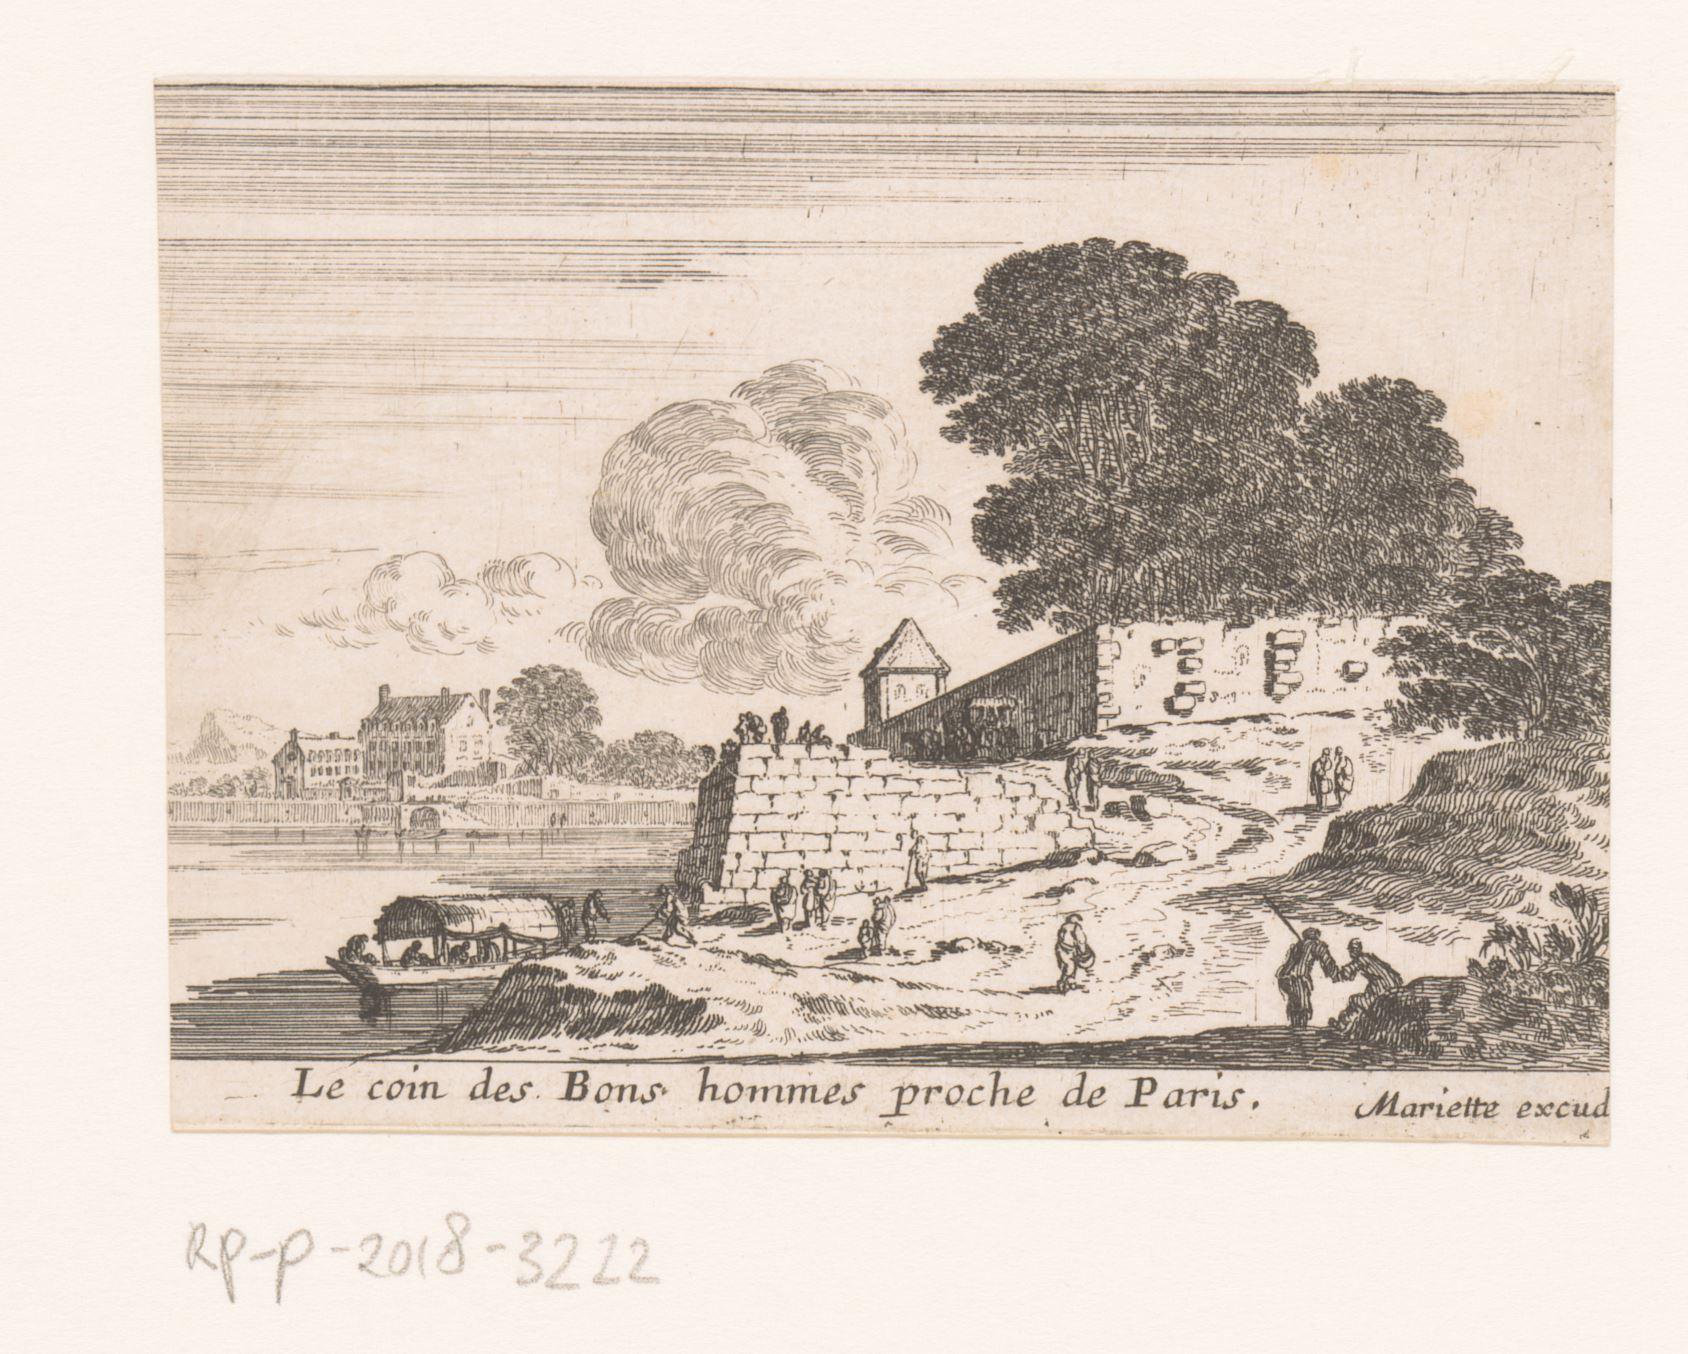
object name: print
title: Diverse gezichten op Frankrijk en Italië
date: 1631-1657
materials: paper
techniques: etching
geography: paris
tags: city-view, and landscape with man-made constructions, abbey, monastery, convent ~ roman catholic church, paris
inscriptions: collector's mark: Lugt 2228, collector's mark: Lugt 240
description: De prent maakt deel uit van een serie van twaalf prenten.